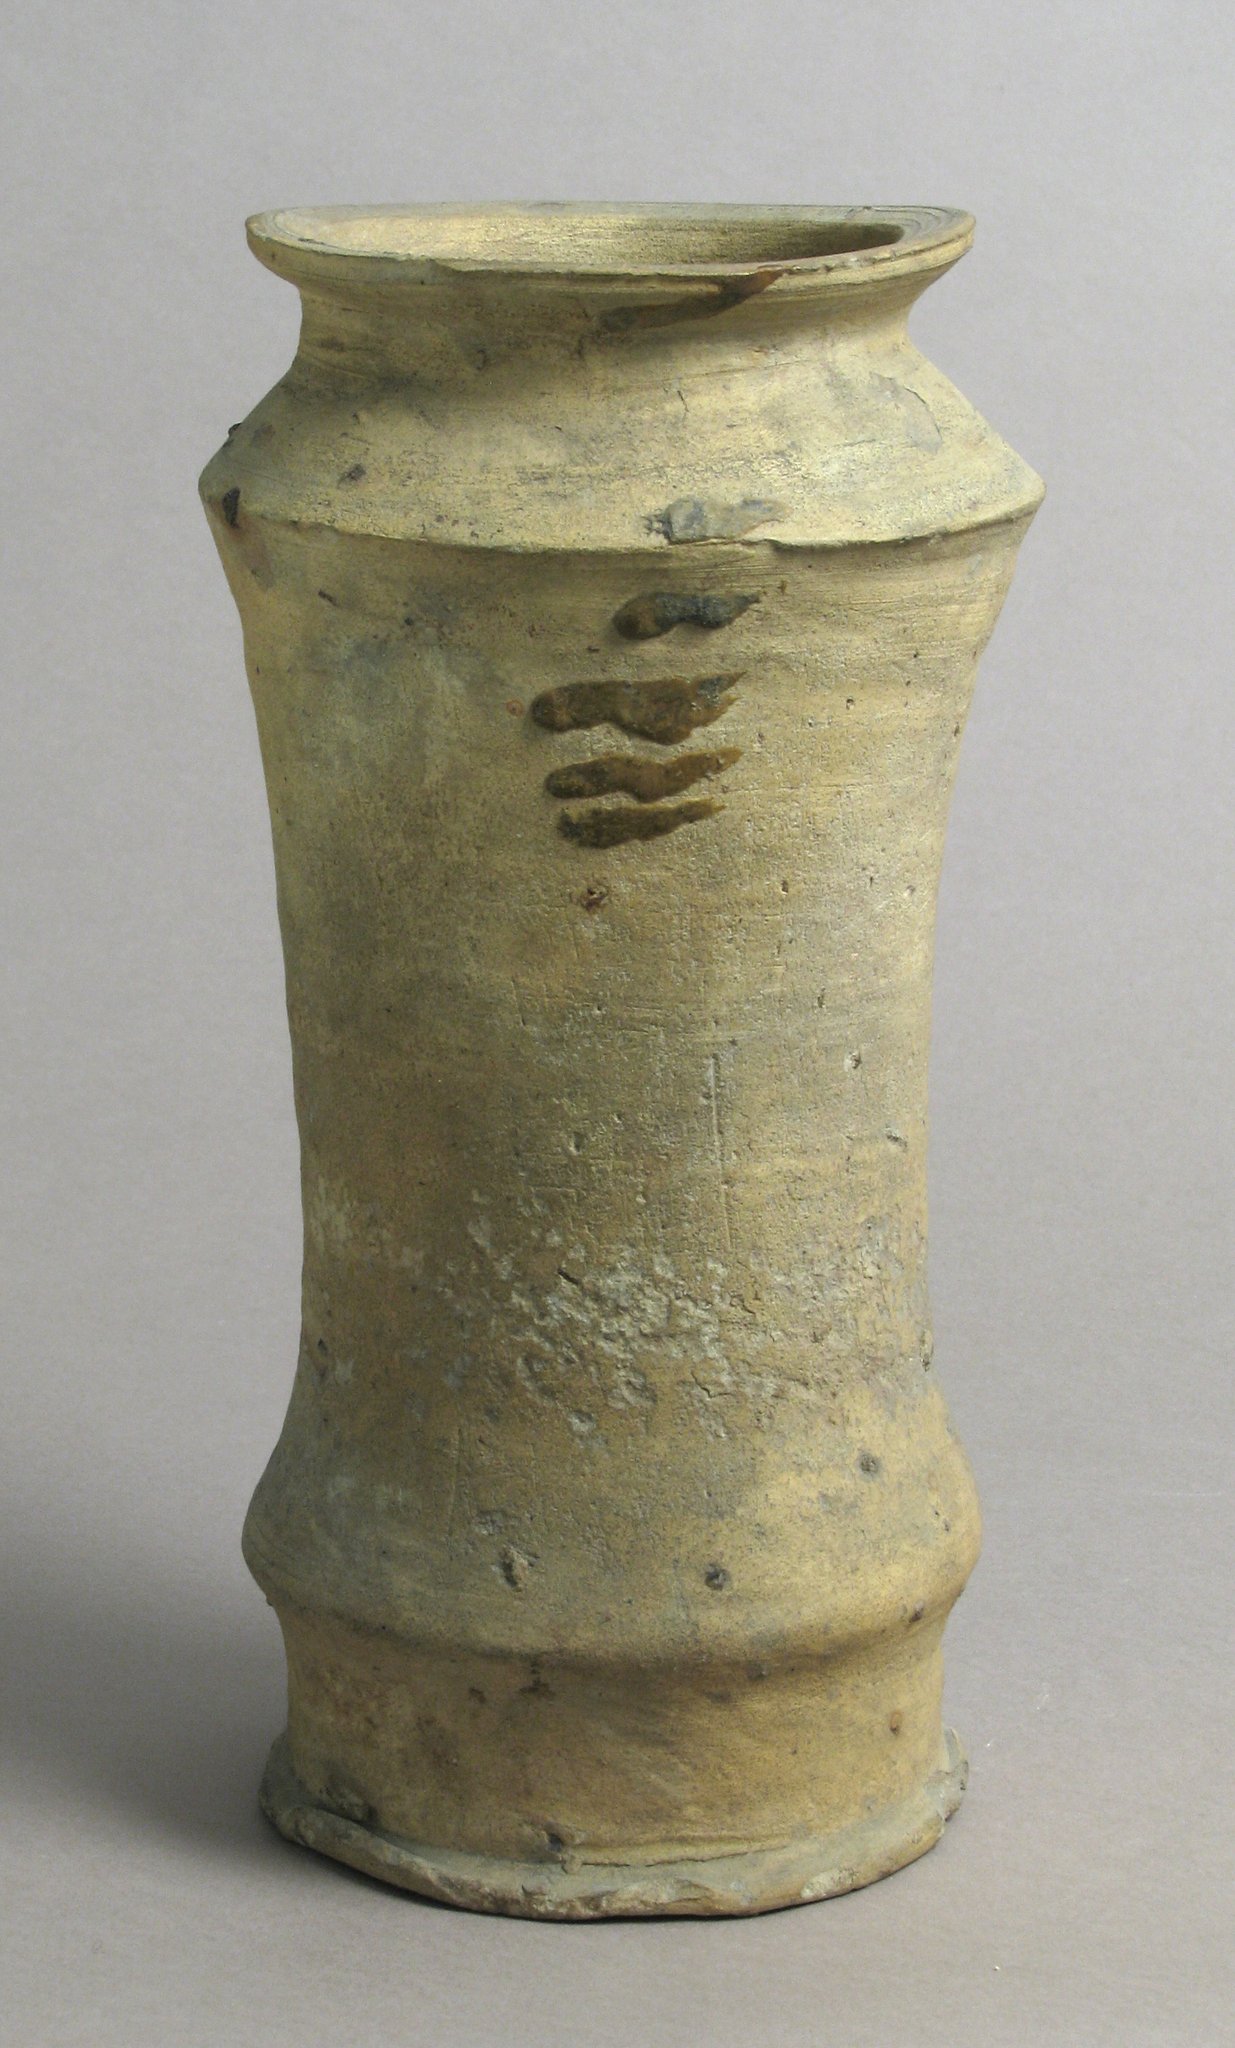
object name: pharmacy jar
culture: french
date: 1401-1500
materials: earthenware